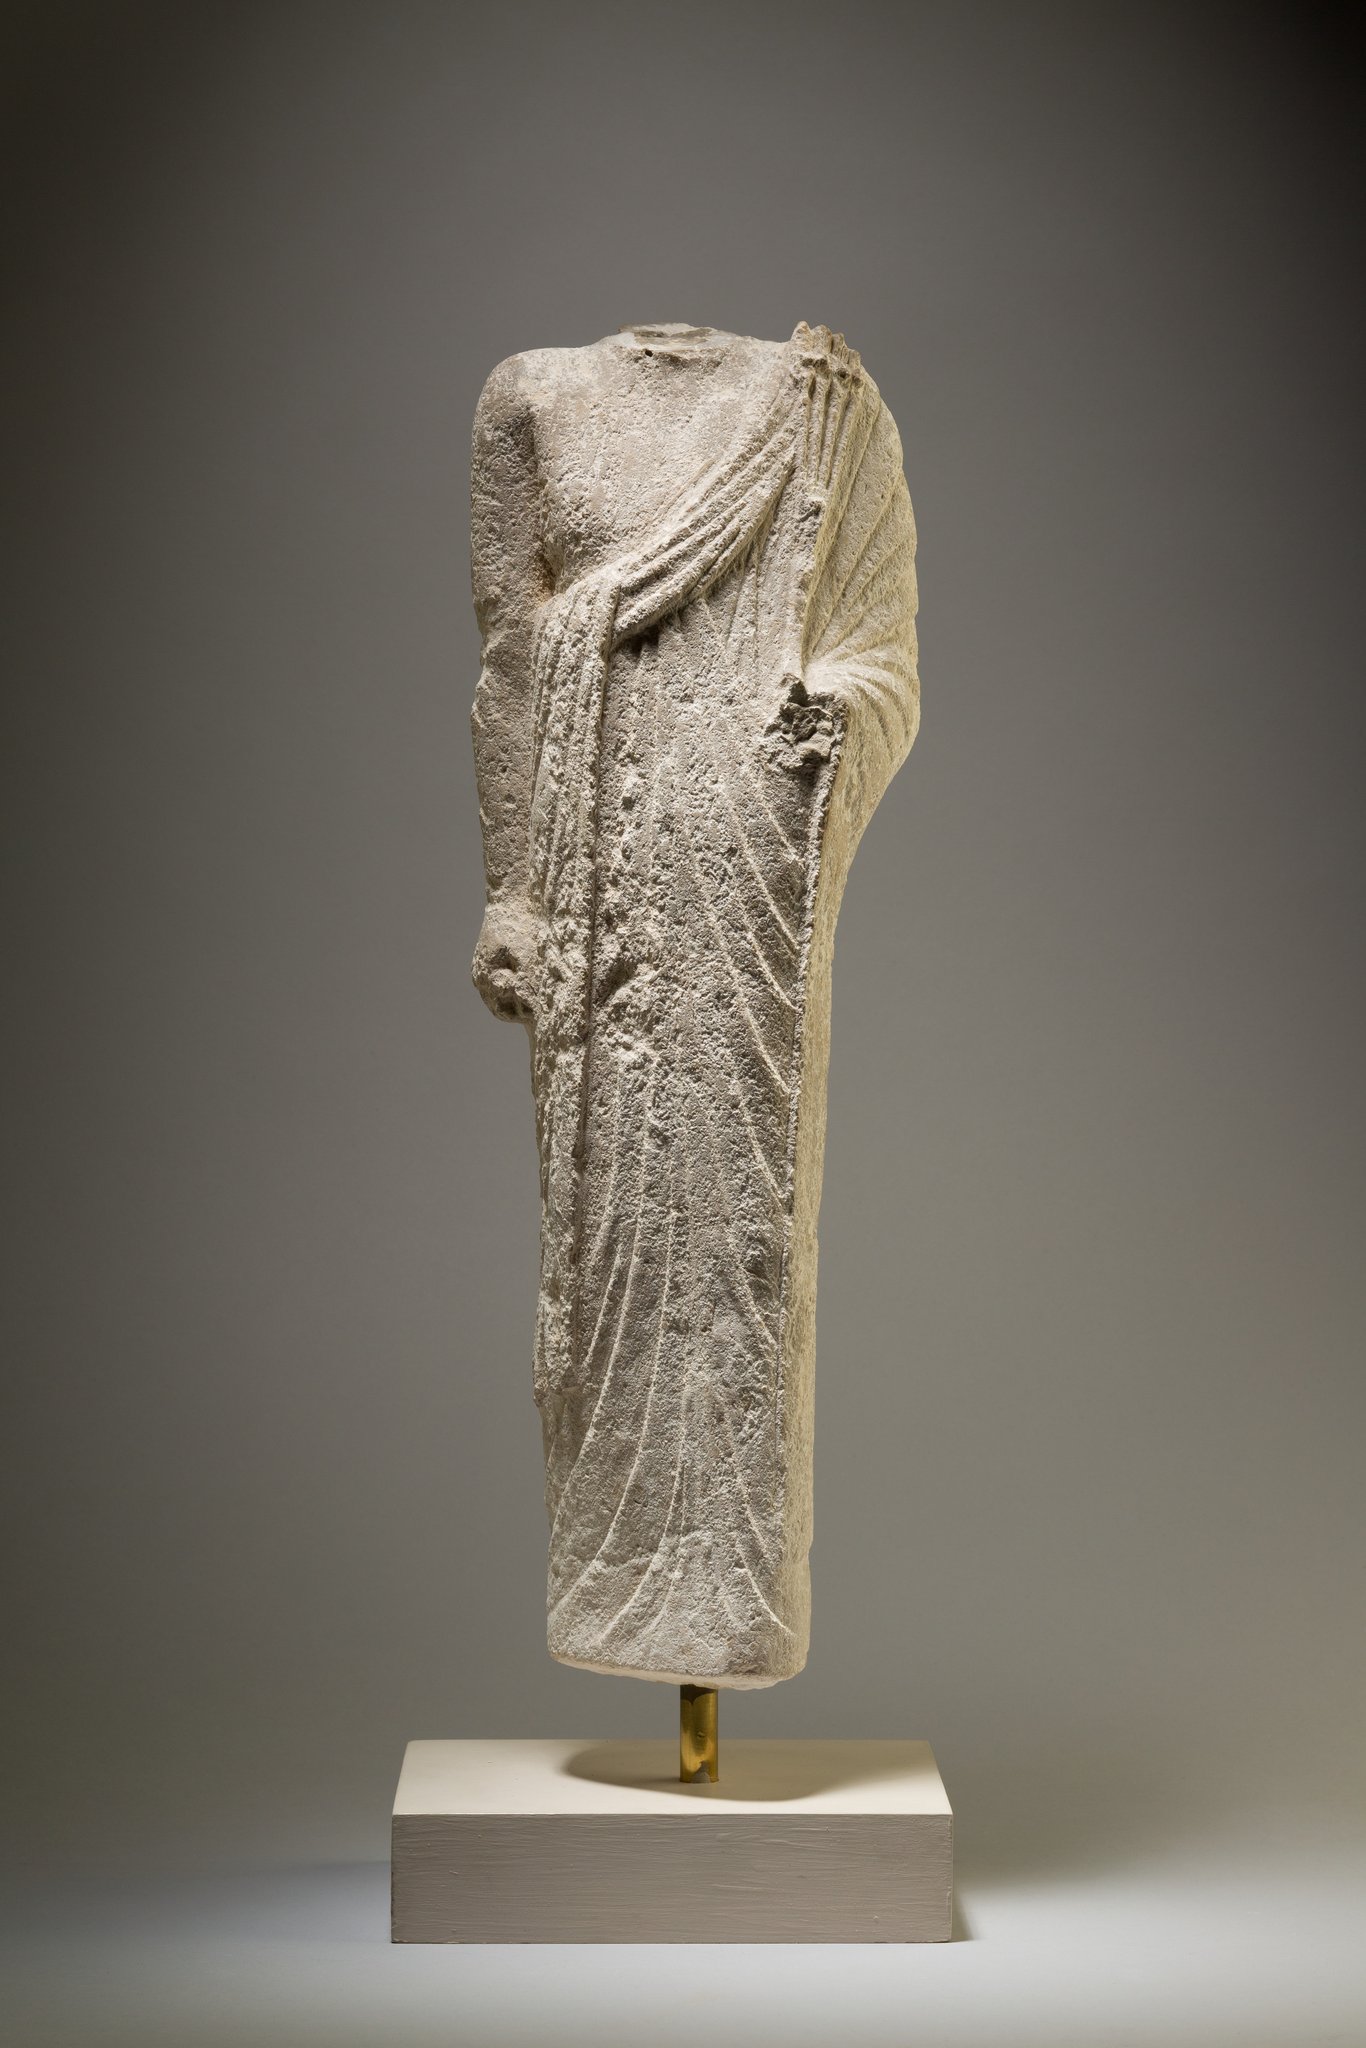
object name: statue, man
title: Statue of Horwedja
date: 100-1 BCE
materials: limestone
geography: egypt